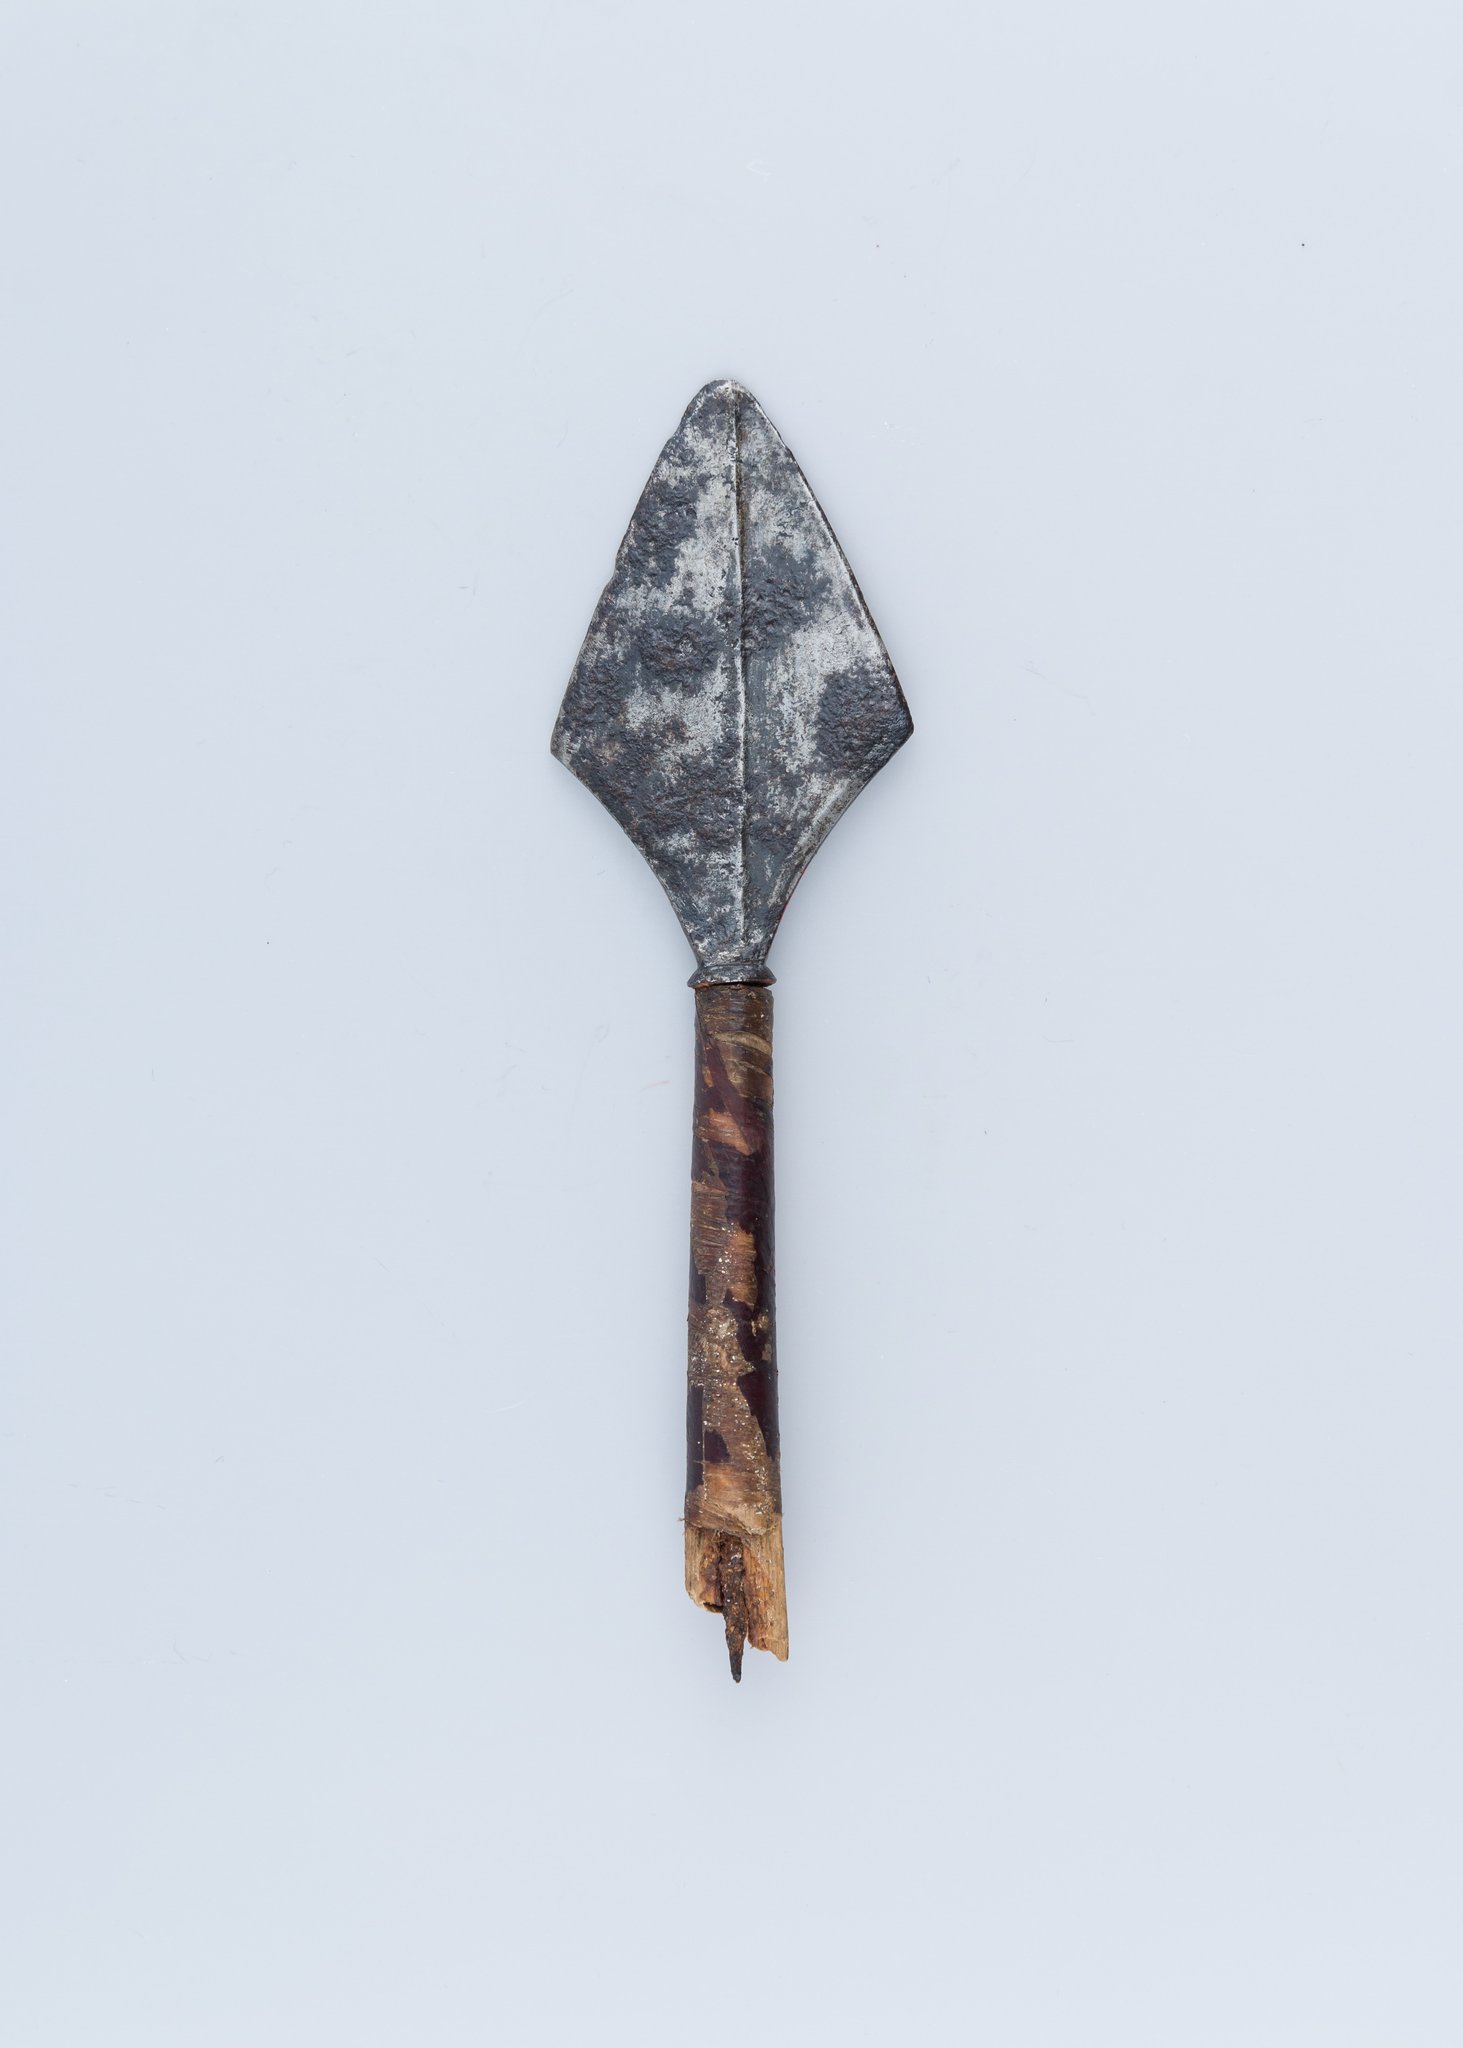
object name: arrowhead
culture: tibetan or chinese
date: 1701-1900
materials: iron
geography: china